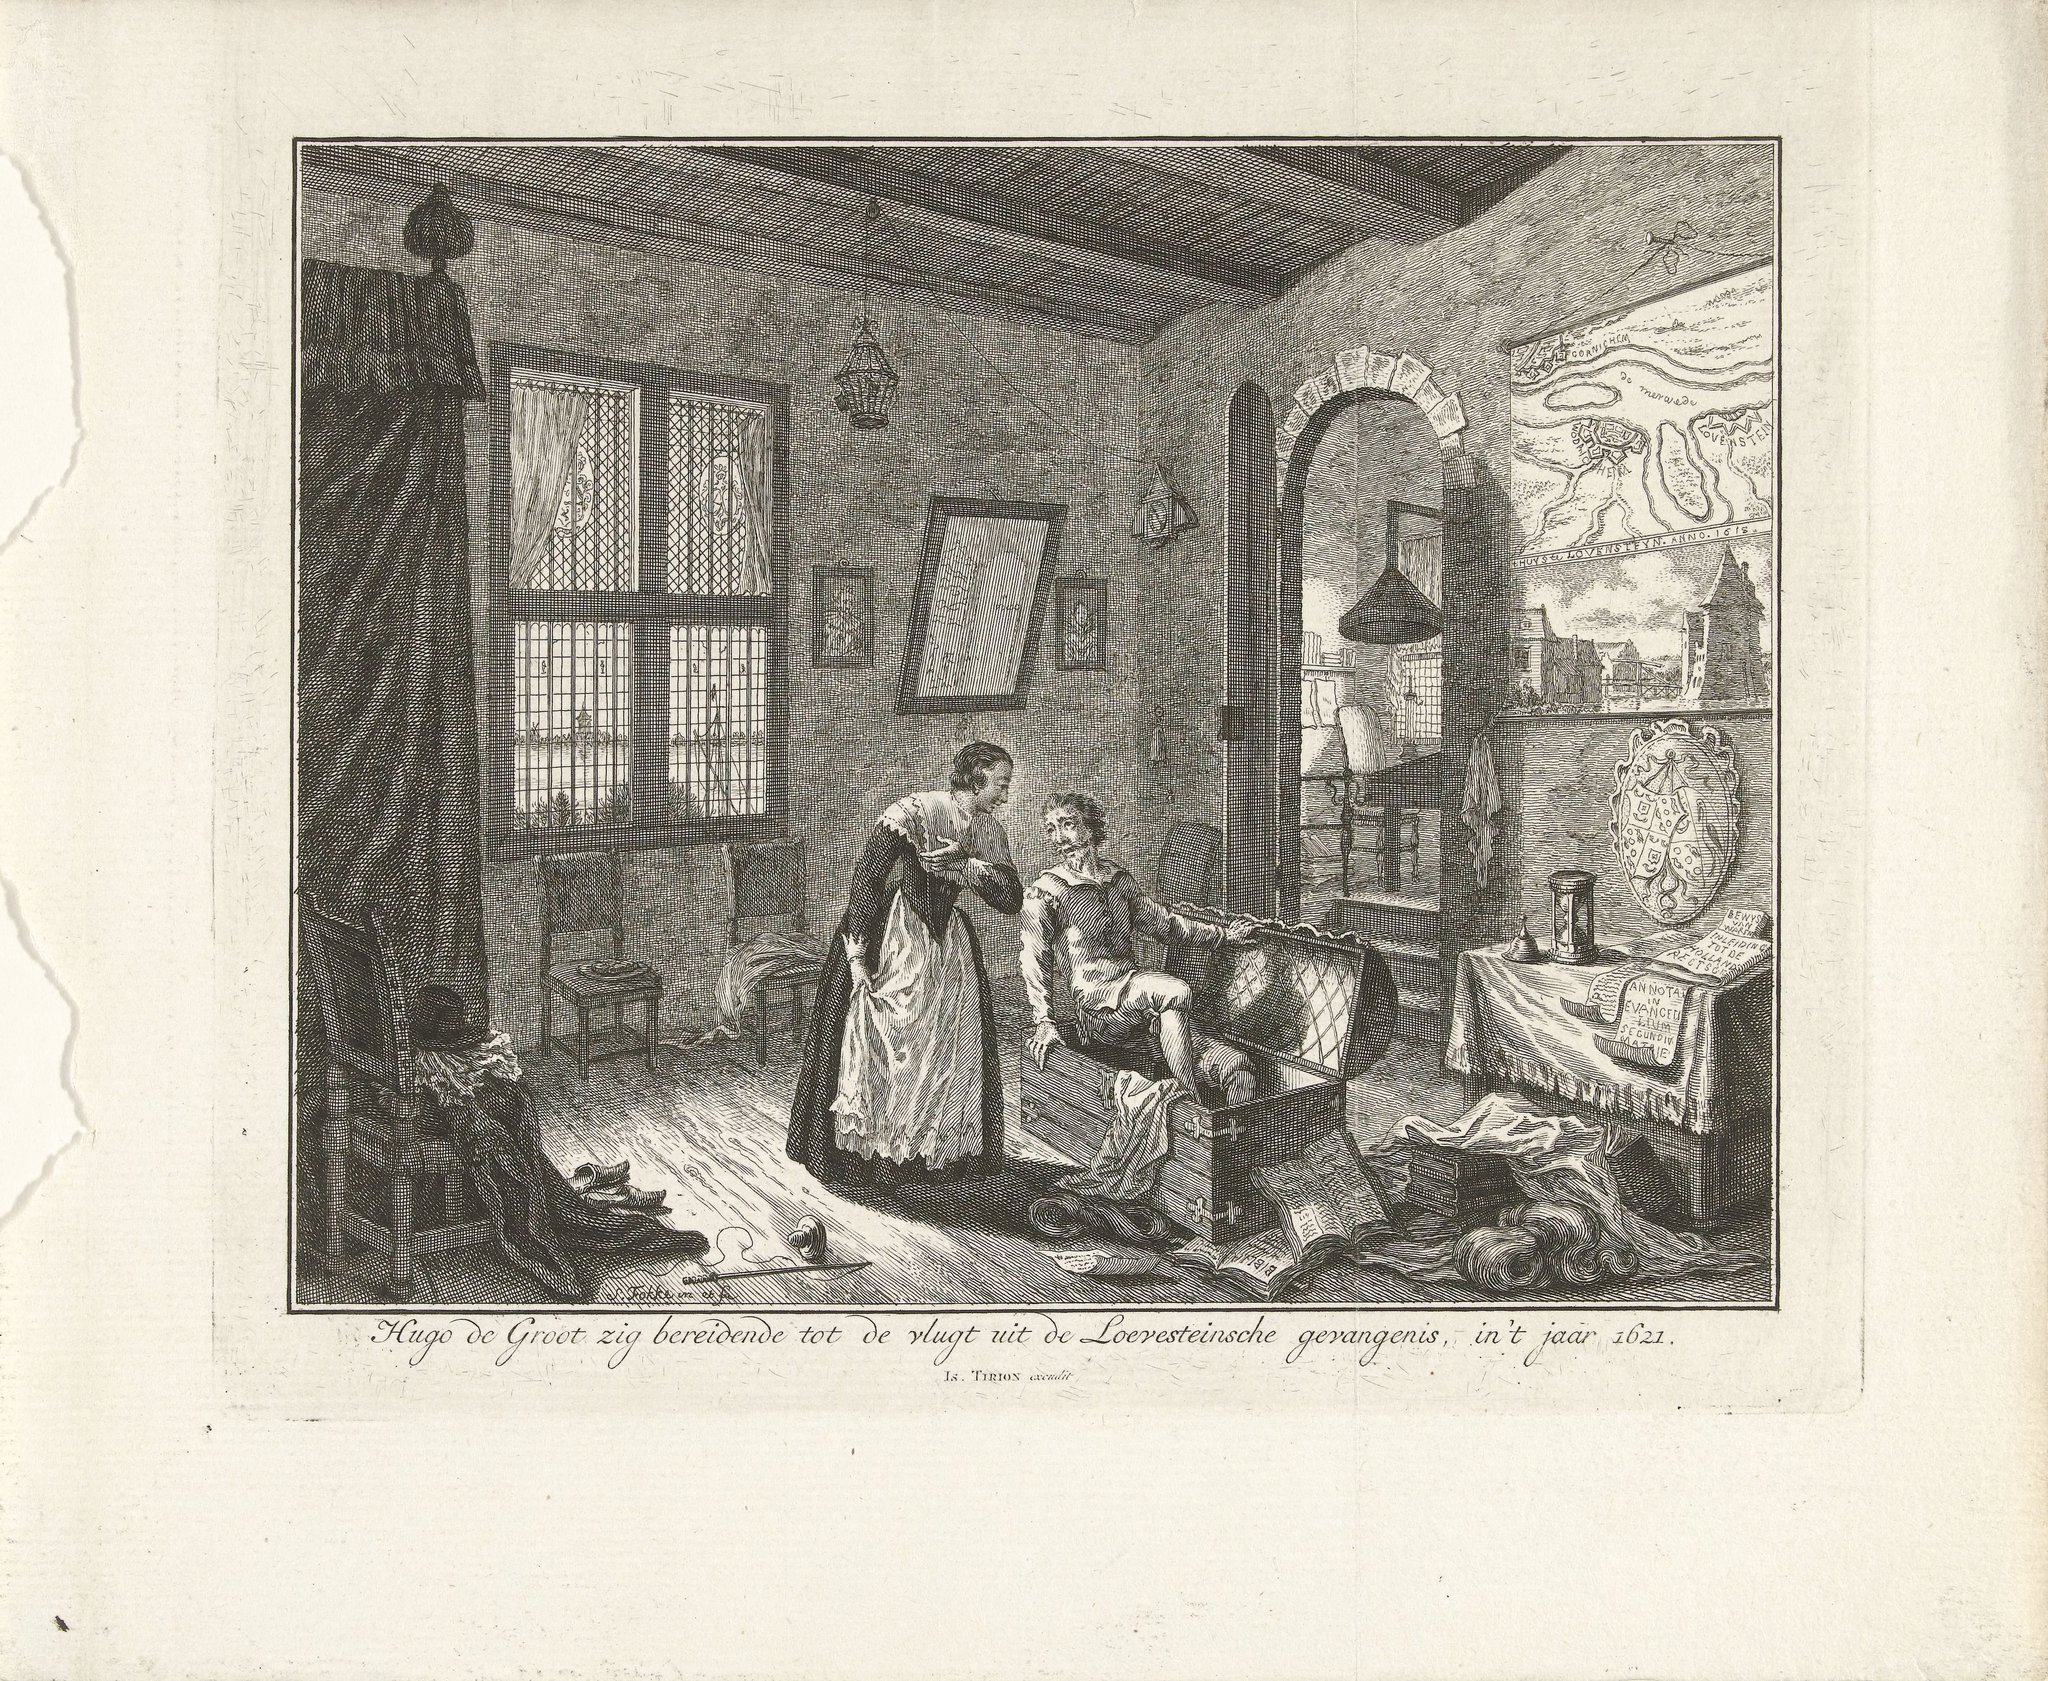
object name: print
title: Maria van Reigersberch en Hugo de Groot bereiden zijn vlucht uit Slot Loevestein voor, 1621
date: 1754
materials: paper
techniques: etching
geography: amsterdam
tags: delft, hugo de groot, law and jurisprudence (+ escape from prison), loevestein castle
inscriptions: collector's mark: Lugt 2228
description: In een vertrek stapt Hugo de Groot in een boekenkist. Naast hem staat zijn echtgenote Maria van Reigersberch, die het plan voor de ontsnapping met de boekenkist had bedacht. Aan de muur een prent, op tafel en op de grond boeken en manuscripten.